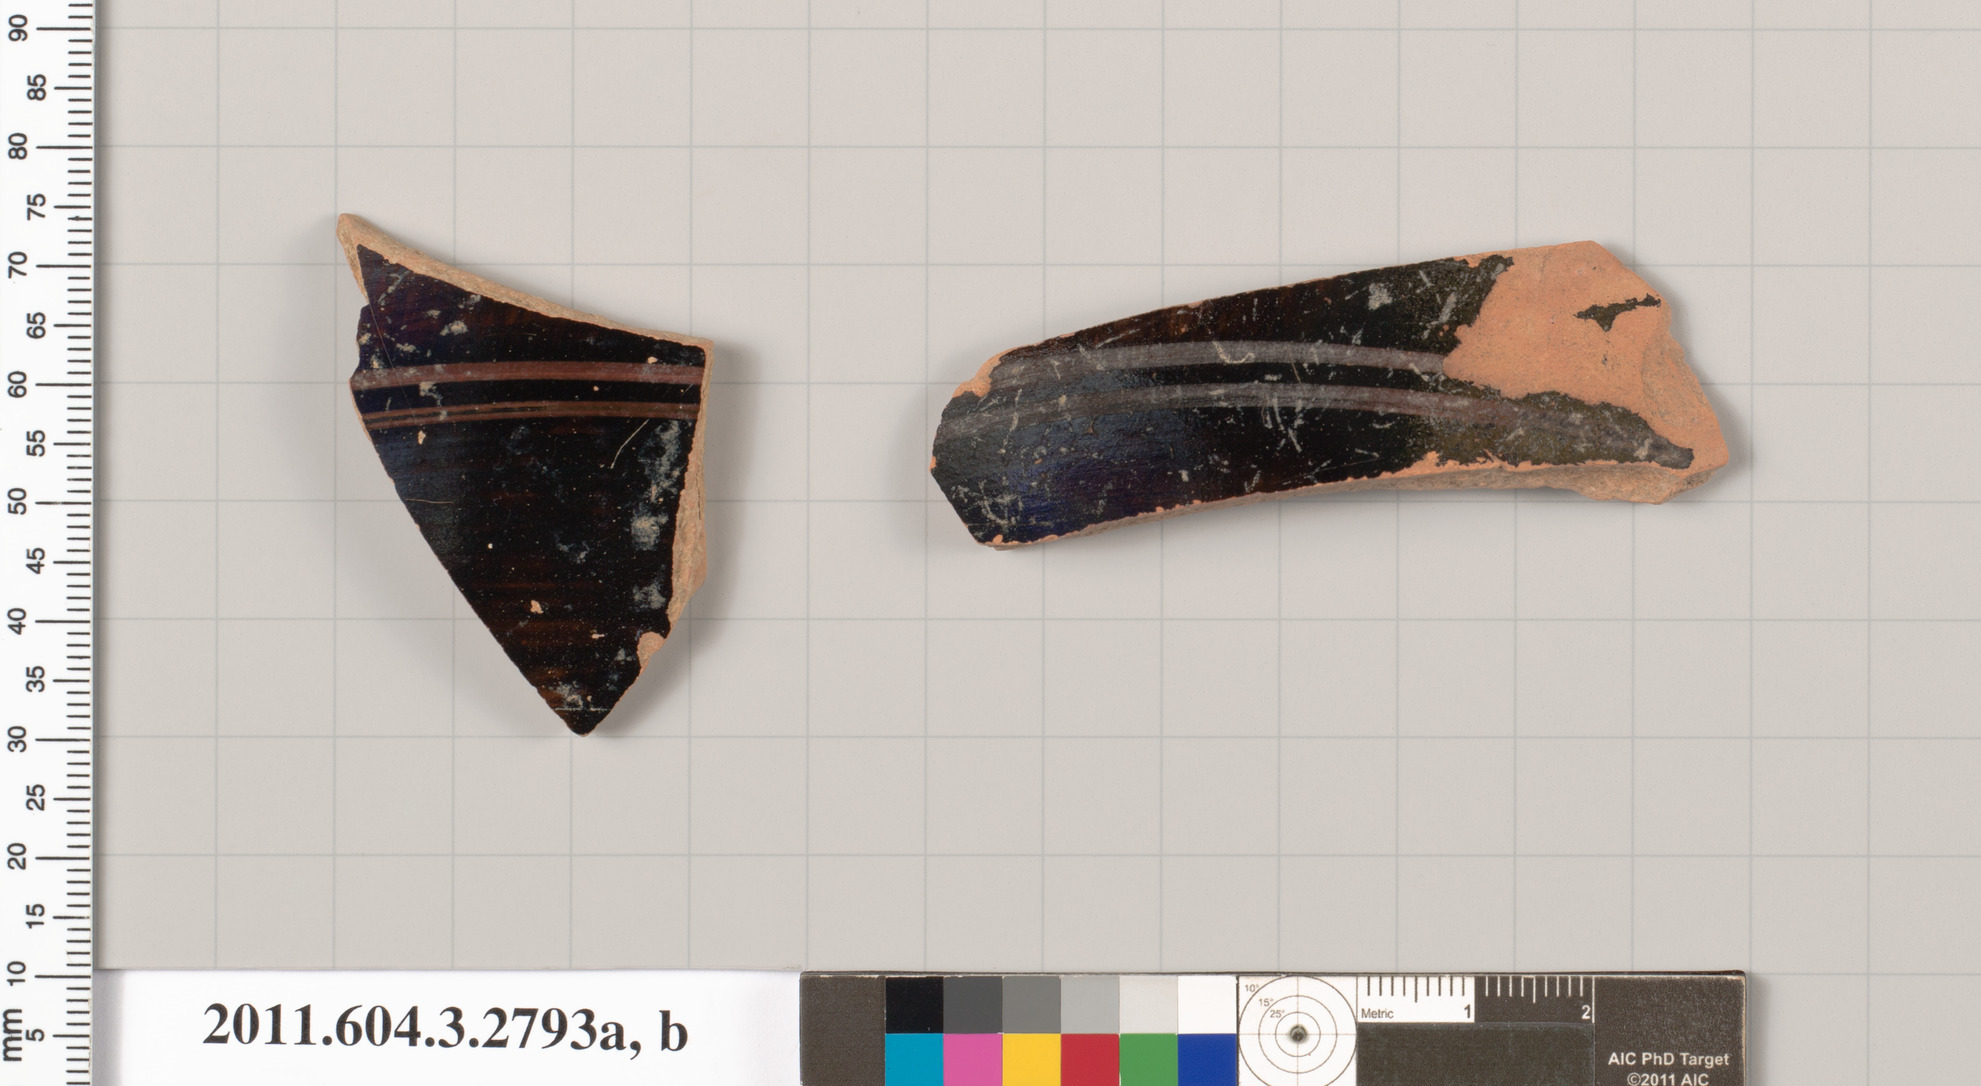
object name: oinochoe or olpe fragment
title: Terracotta fragments of oinochoai (jugs) or olpai (jugs)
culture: greek, attic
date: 600-401 BCE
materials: terracotta